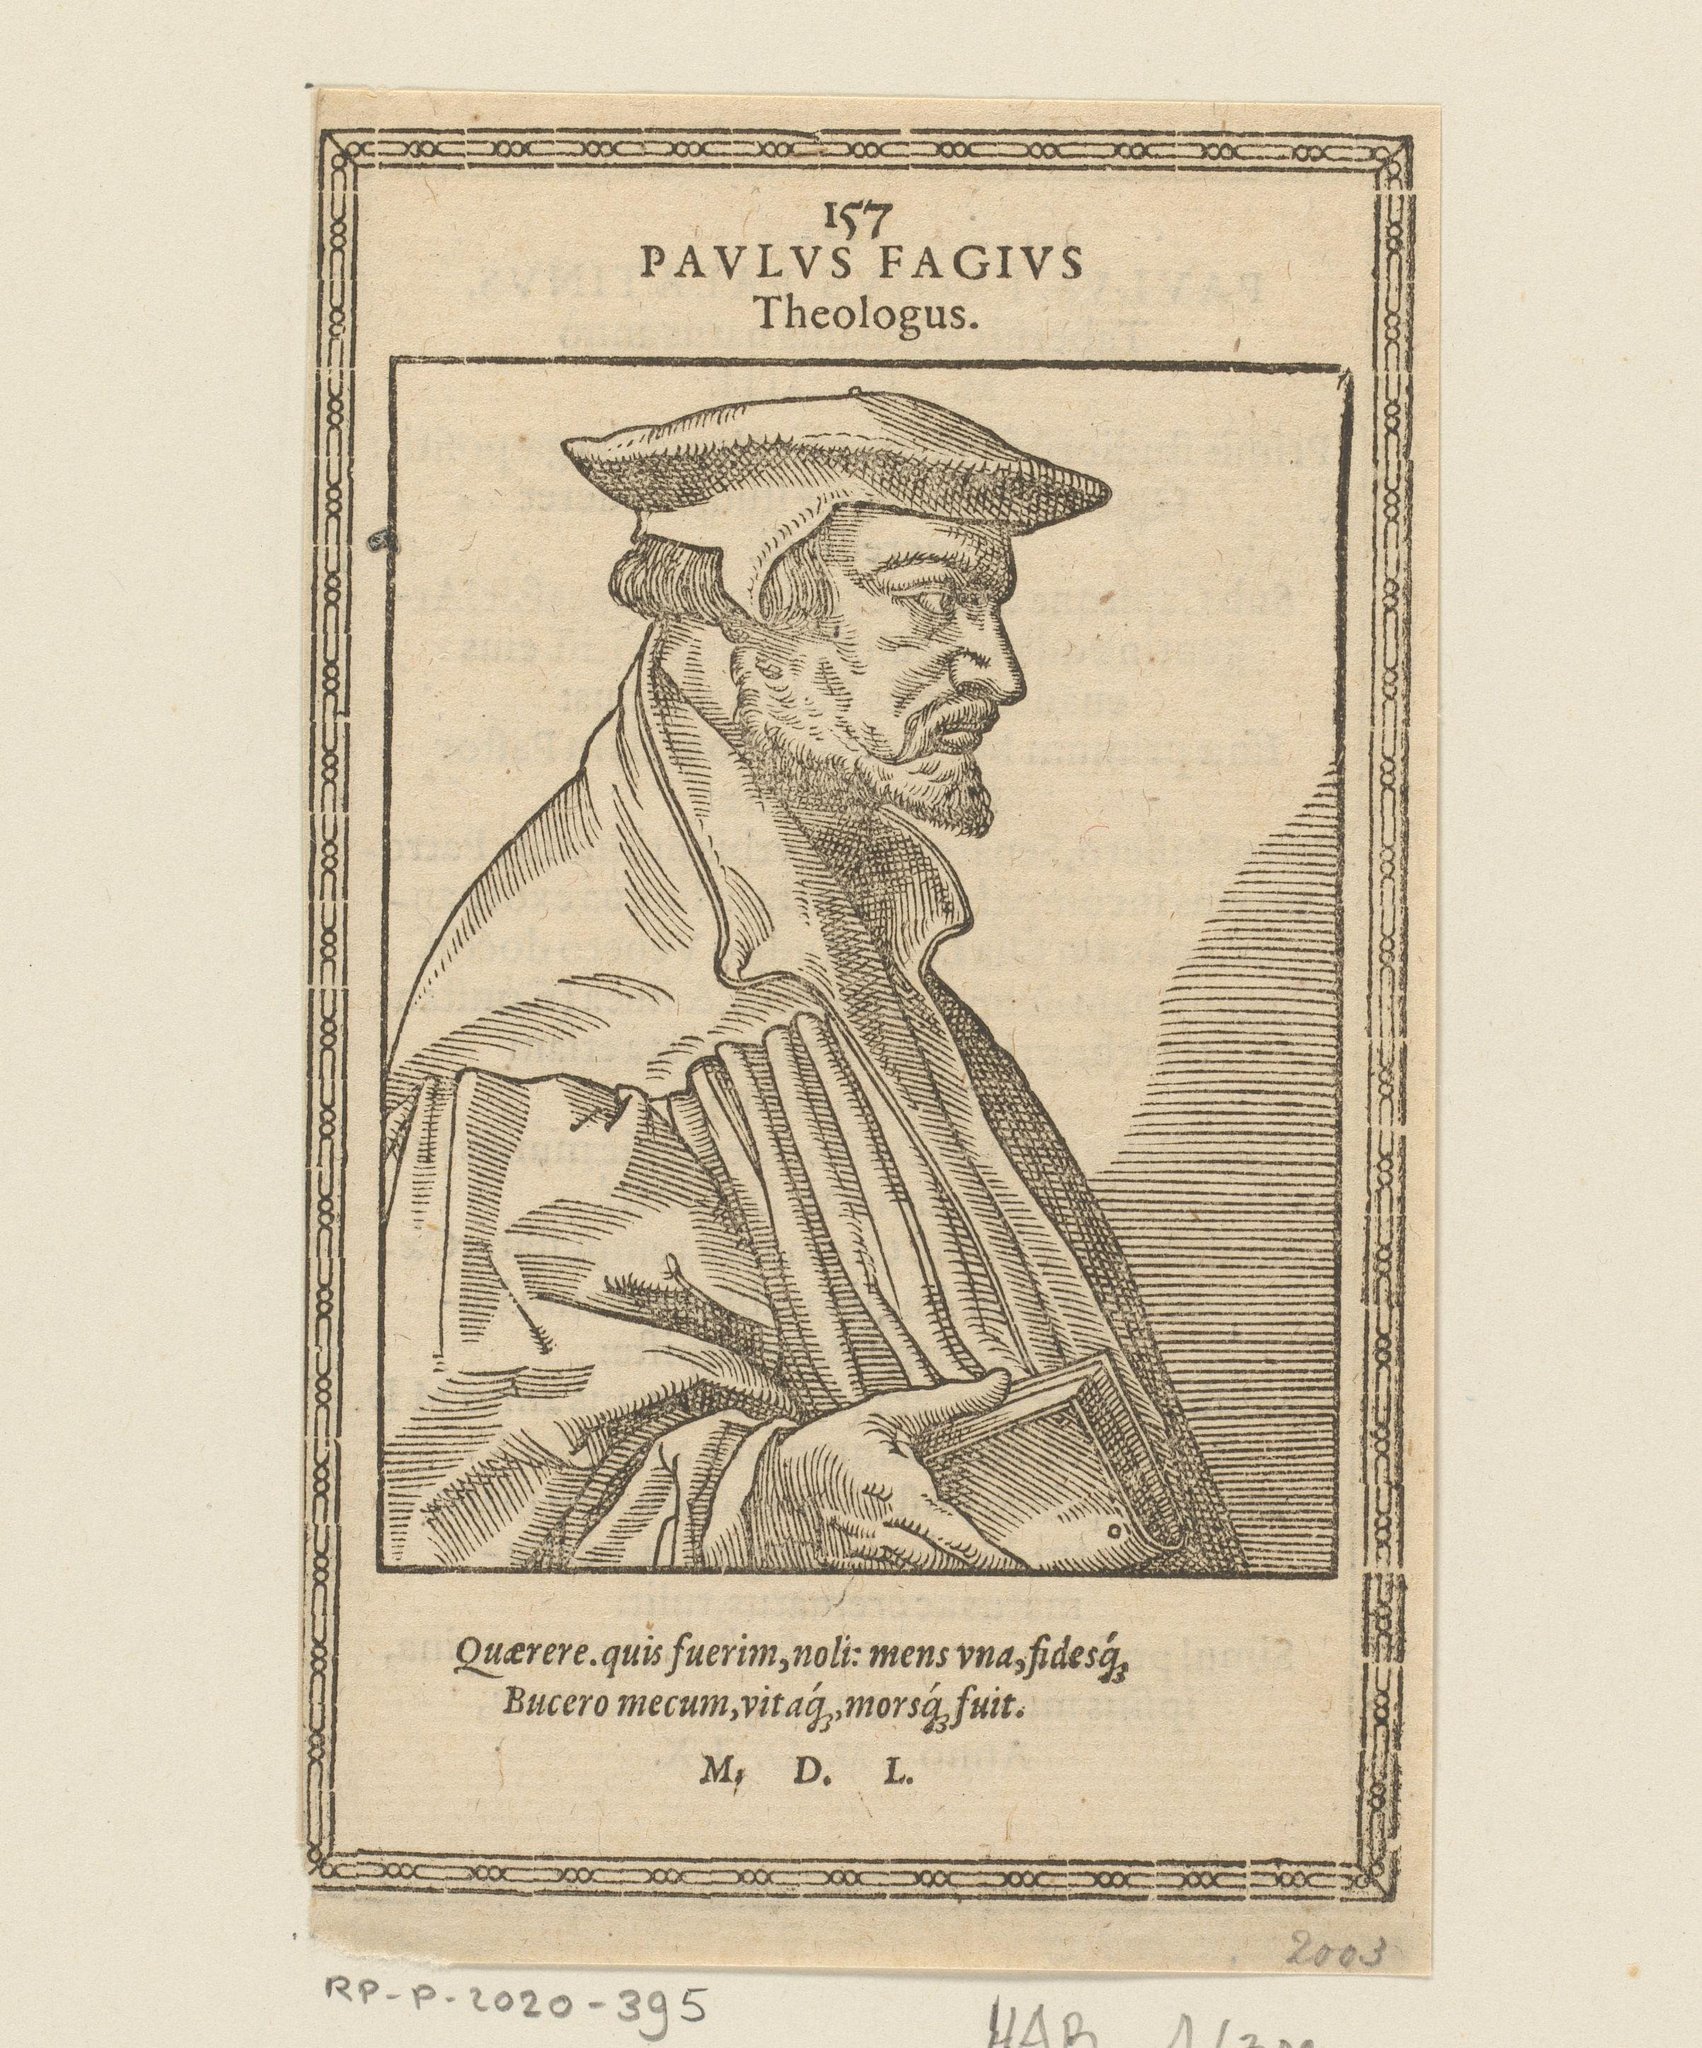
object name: print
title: Portret van Paul Fagius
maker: bernhard jobin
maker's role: printer, publisher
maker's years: 1545-1593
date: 1590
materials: paper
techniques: letterpress printing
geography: straatsburg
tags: theologian, historical persons, book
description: Prent uit: Reusner, Nikolaus. Icones sive imagines virorum literis illustrium (...). Straatsburg: Bernhard Jobin, 1590, p. 157. Prent voor het eerst verschenen in de eerste editie van 1587. Prent ook gebruikt in latere publicaties.